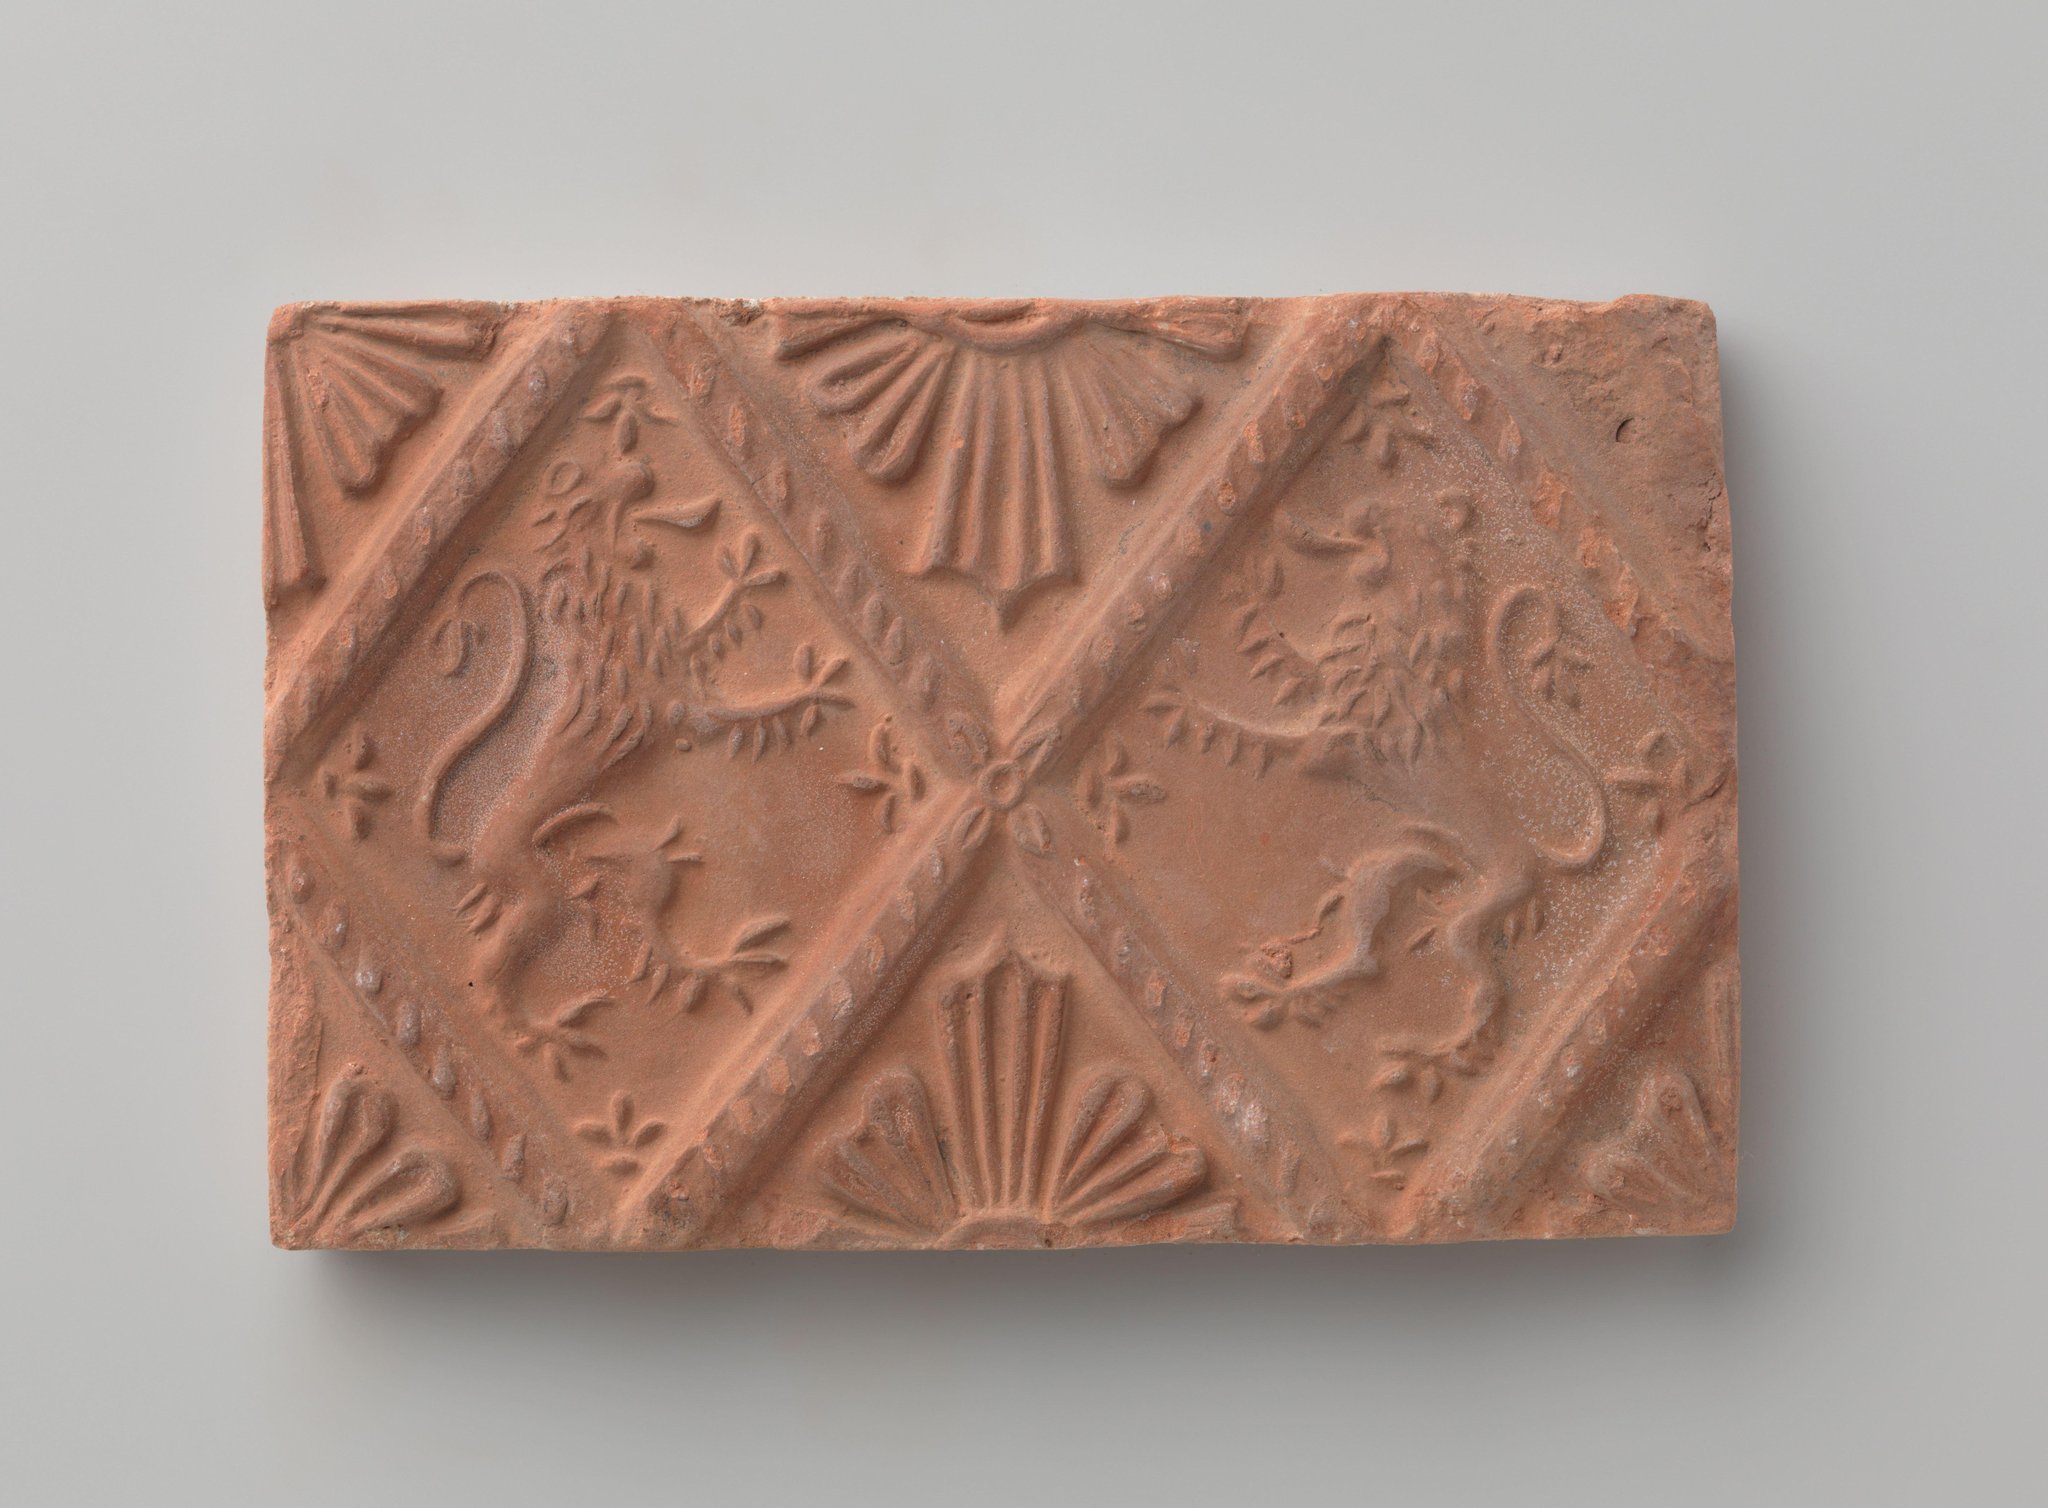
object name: hearthstone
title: Haardsteen met voorstelling van twee klimmende leeuwen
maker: Anonymous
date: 1875-1900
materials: earthenware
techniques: printing, firing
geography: netherlands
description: Haardsteen met voorstelling van twee klimmende leeuwen, geplaatst in geprofileerde ruit. De halve ruiten aan de boven- en onderkant zijn opgevuld met stermotief.